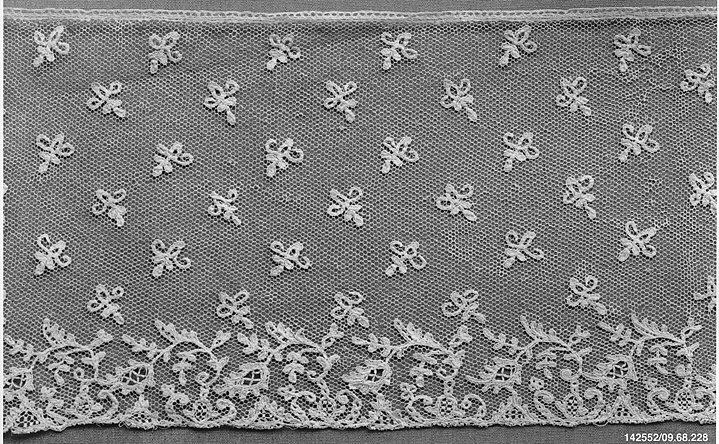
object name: piece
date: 1767-1800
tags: flowers,leaves